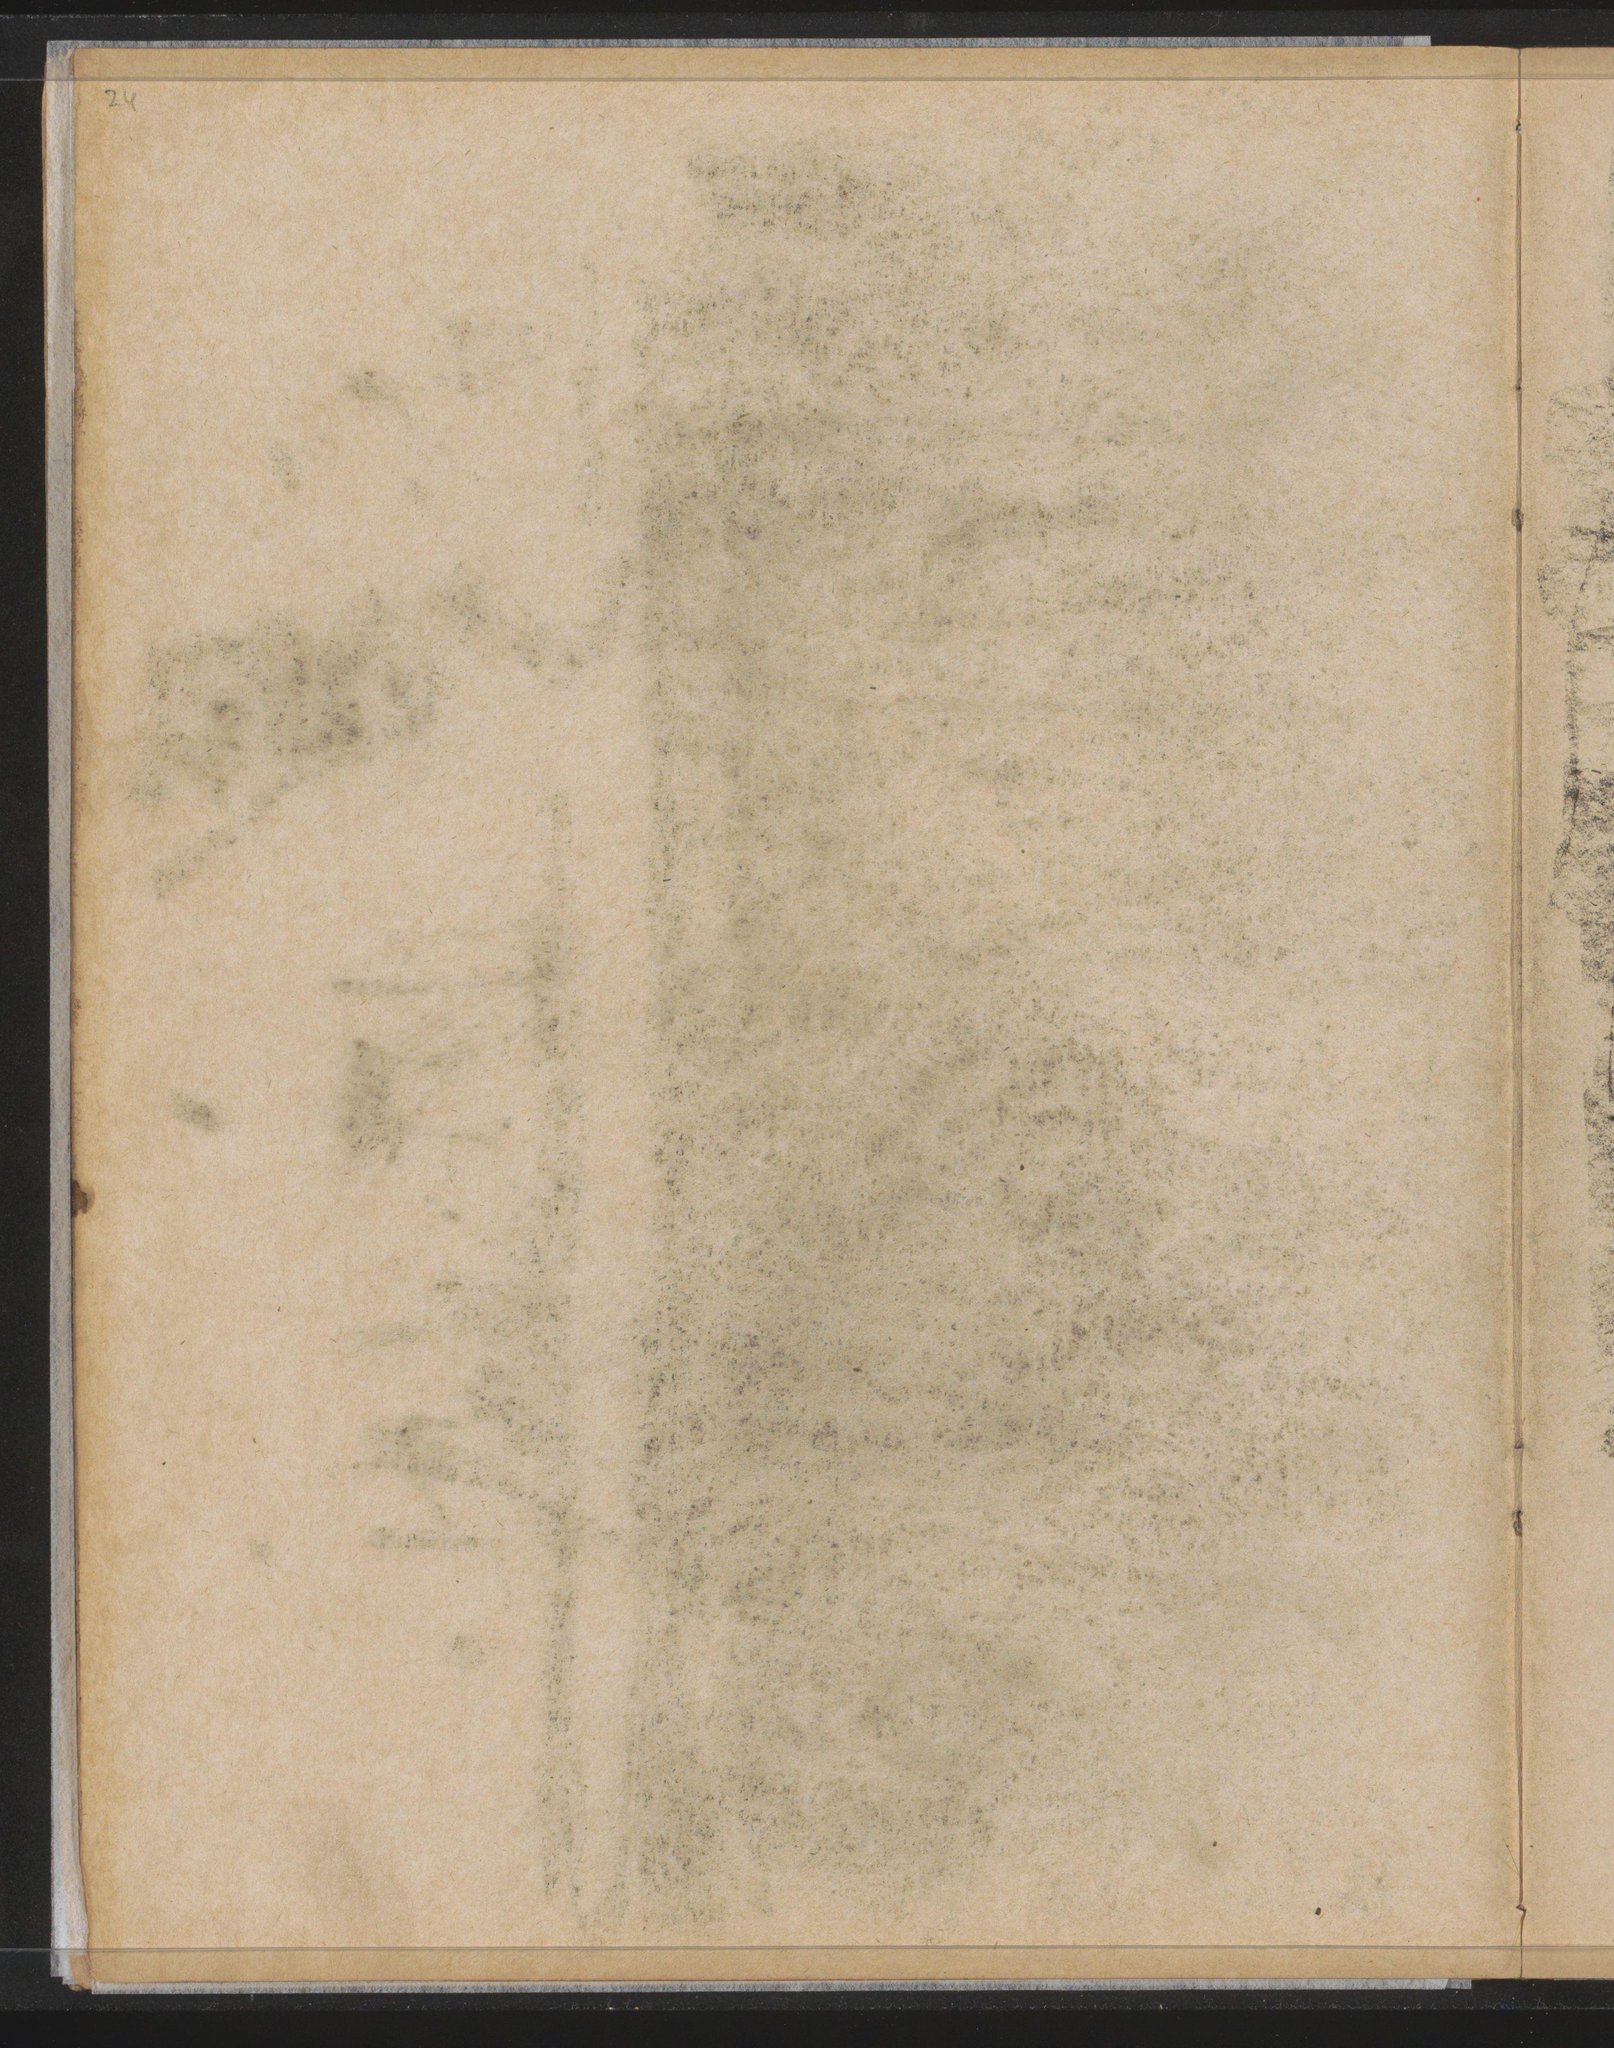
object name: sketchbook leaf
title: Abklatsch van de krijttekening op pagina 25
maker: willem witsen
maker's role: draughtsman, painter, print maker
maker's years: 1860-1923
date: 1887-1888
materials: paper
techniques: printmaking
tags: rural housing, e.g. country-house, villa, cottage, gate, entrance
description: Pagina 24 uit een schetsboek met 43 bladen.